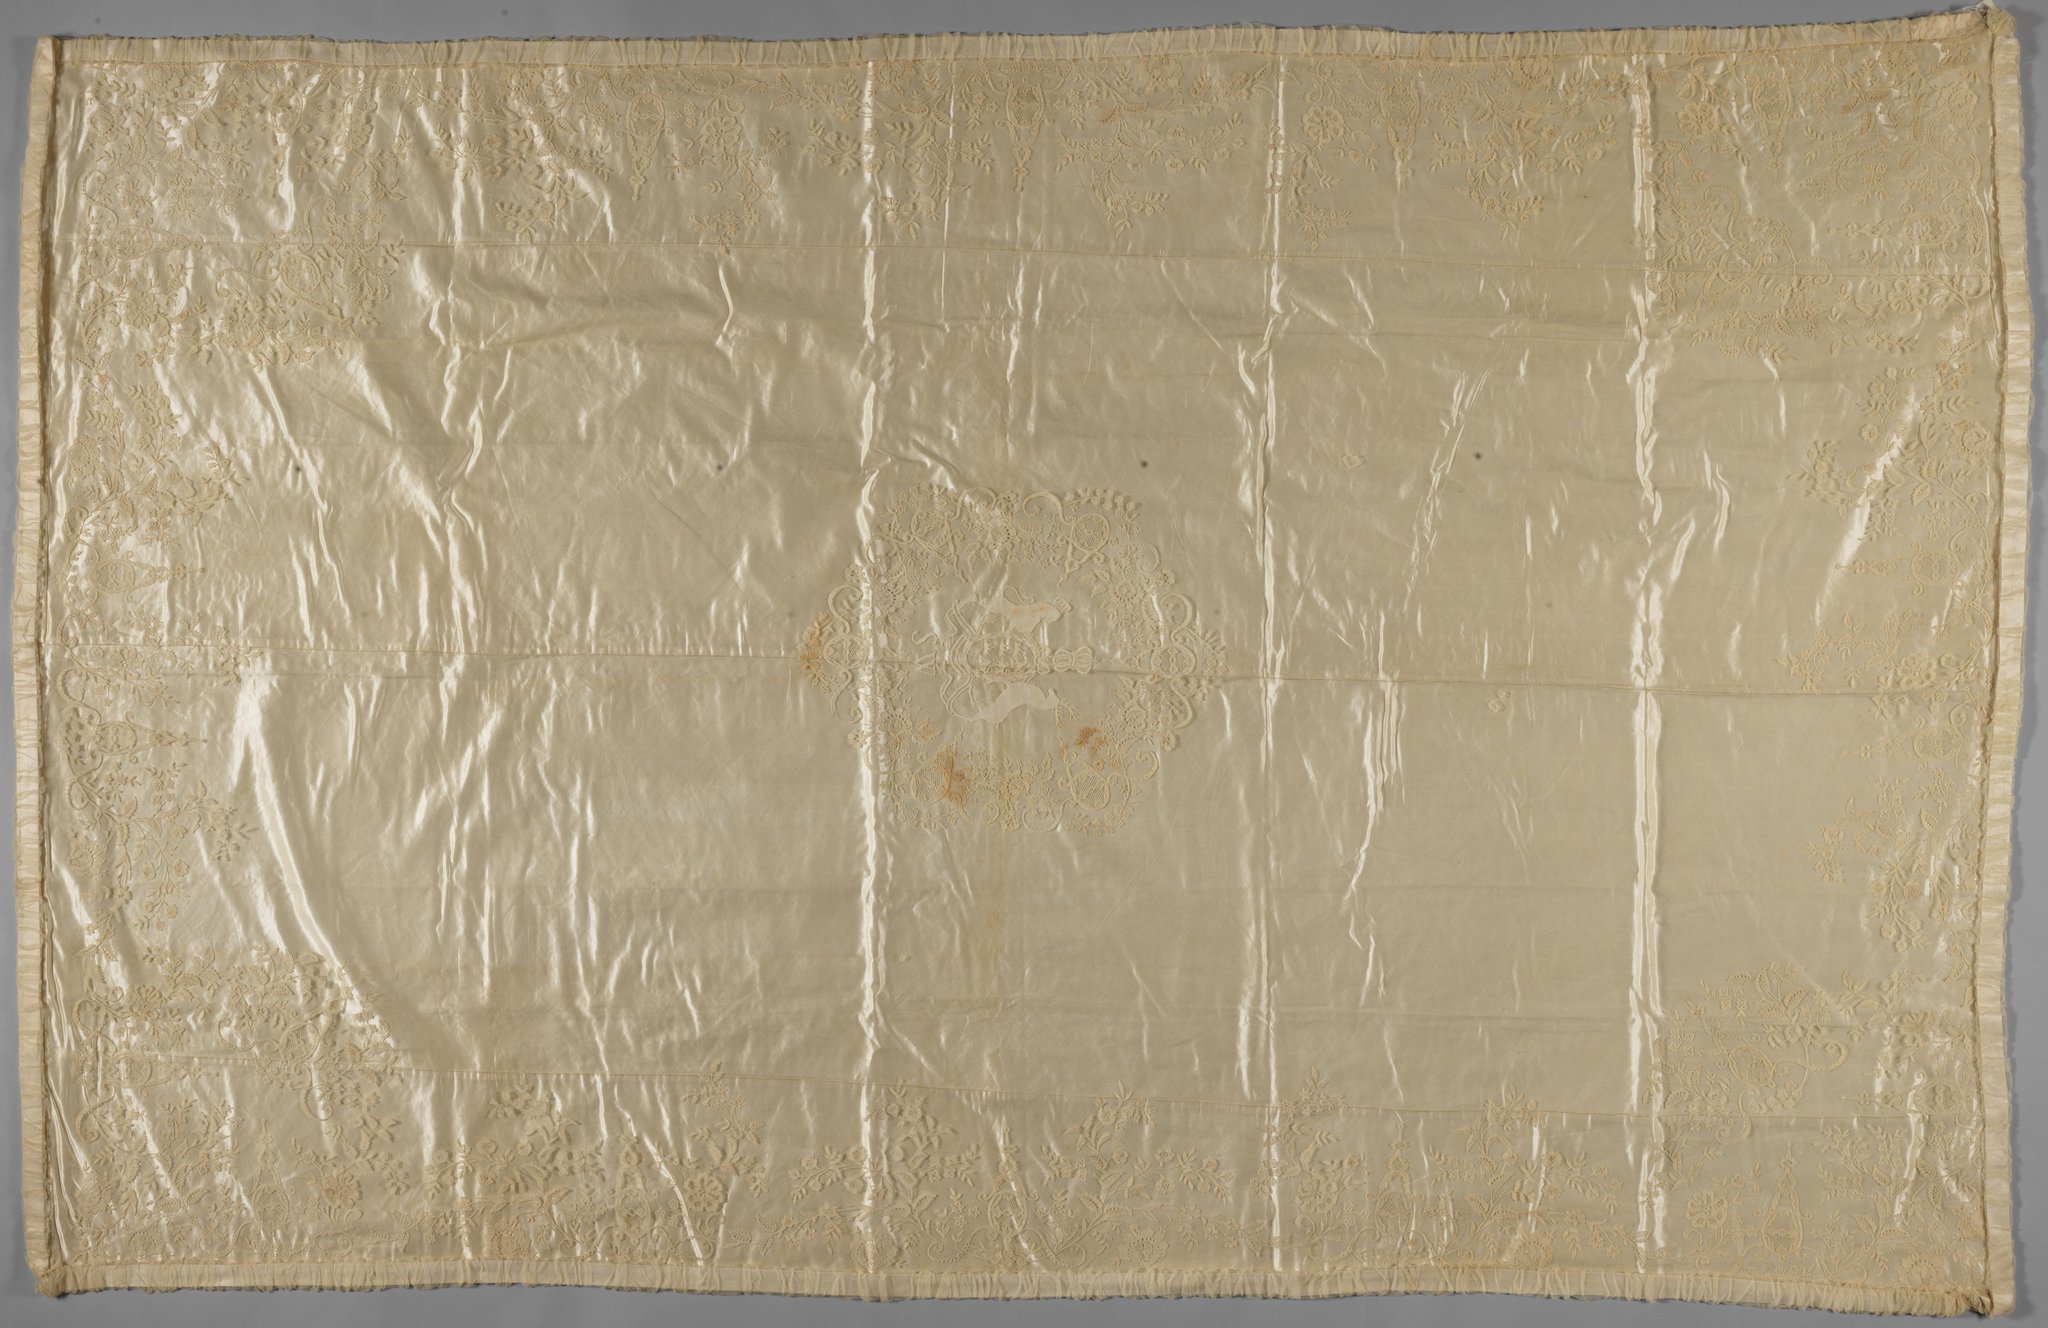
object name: bedspread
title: Sprei van applicatiekant van Koningin Sophie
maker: Anonymous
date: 1839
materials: linen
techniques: lace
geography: belgium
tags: armorial bearing, heraldry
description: Sprei van naturelkleurige applicatiekant, naaldkant - Brusselse gaaskant - geappliceerd op machinale tule. In het midden van een tule rechthoek staat, binnen een krans, het ovale wapenschild van Wurtemberg, gehouden door een gekroonde klimmende leeuw en een klimmend hert en gedekt door een gekroonde helm. Onder een lege banderolle zijn de grote initialen, S en W aangebracht. De krans is opgebouwd uit een slingerende rozentak, onderbroken door zes staande ovale medaillons, die gedekt zijn door een koepeltje met uivormige, naar het midden gekeerde spits. Een groot ovaal midden is uitgespaard door de rand, die uit grotere overkoepelde ovalen en symmetrische takken bestaat; aan de takken groeien grote rozen, anjers, bloesemtakken en lange, ingesneden blaadjes. Een roomkleurig satijnen ondergrond en een met tule bedekte opgenaaide rechte rand voltooien de sprei, die versierd is met grote crême strikken op de rand, bij het hoofdeinde, en op de hoeken. Het bijbehorende kussenovertrek heeft nagenoeg hetzelfde patroon op kleinere schaal. De rand is echter zachtrose, zonder strikken.